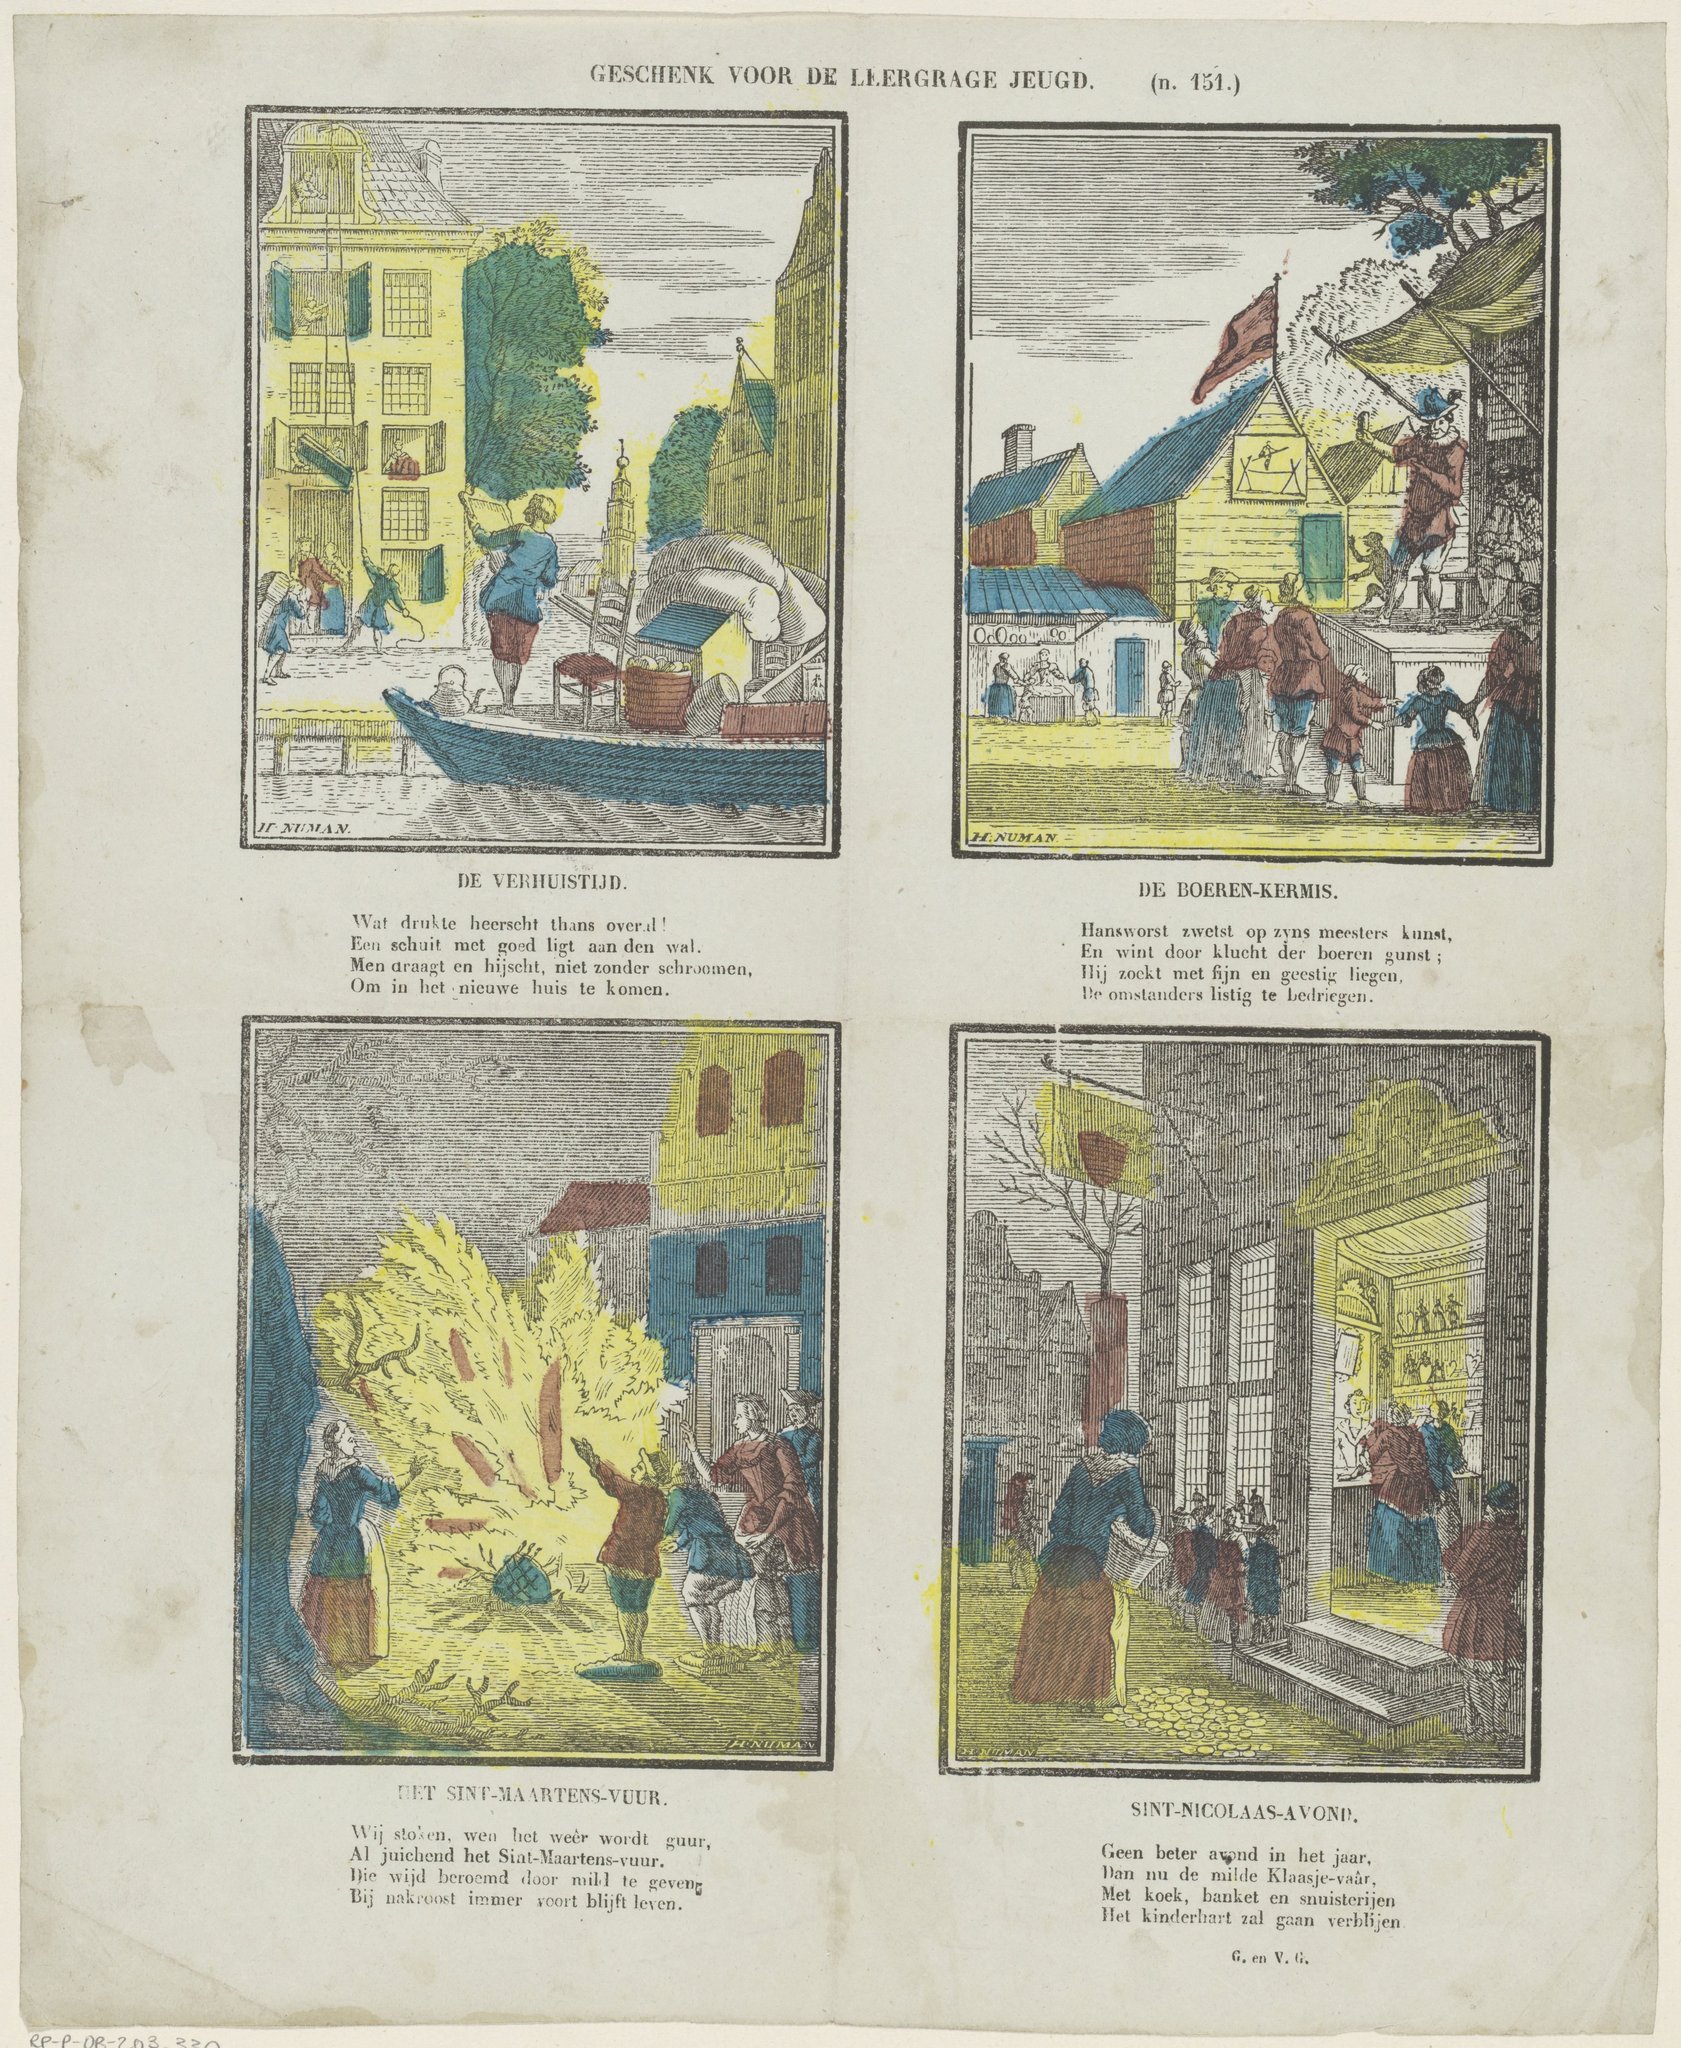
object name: print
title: Geschenk voor de leergrage jeugd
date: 1833-1856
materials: paper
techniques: colour, letterpress printing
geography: turnhout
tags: moving (house), st. martin's day (november 11), festivities on st. nicholas (eve) (december 5), pleasure fair and circus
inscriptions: collector's mark: Lugt 2760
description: Blad met 4 voorstellingen van de verhuistijd, de boerenkermis, het Sint Maartensvuur en Sinterklaasavond. Onder elke afbeelding een titel en een vierregelig vers. Genummerd rechtsboven: (n. 151).